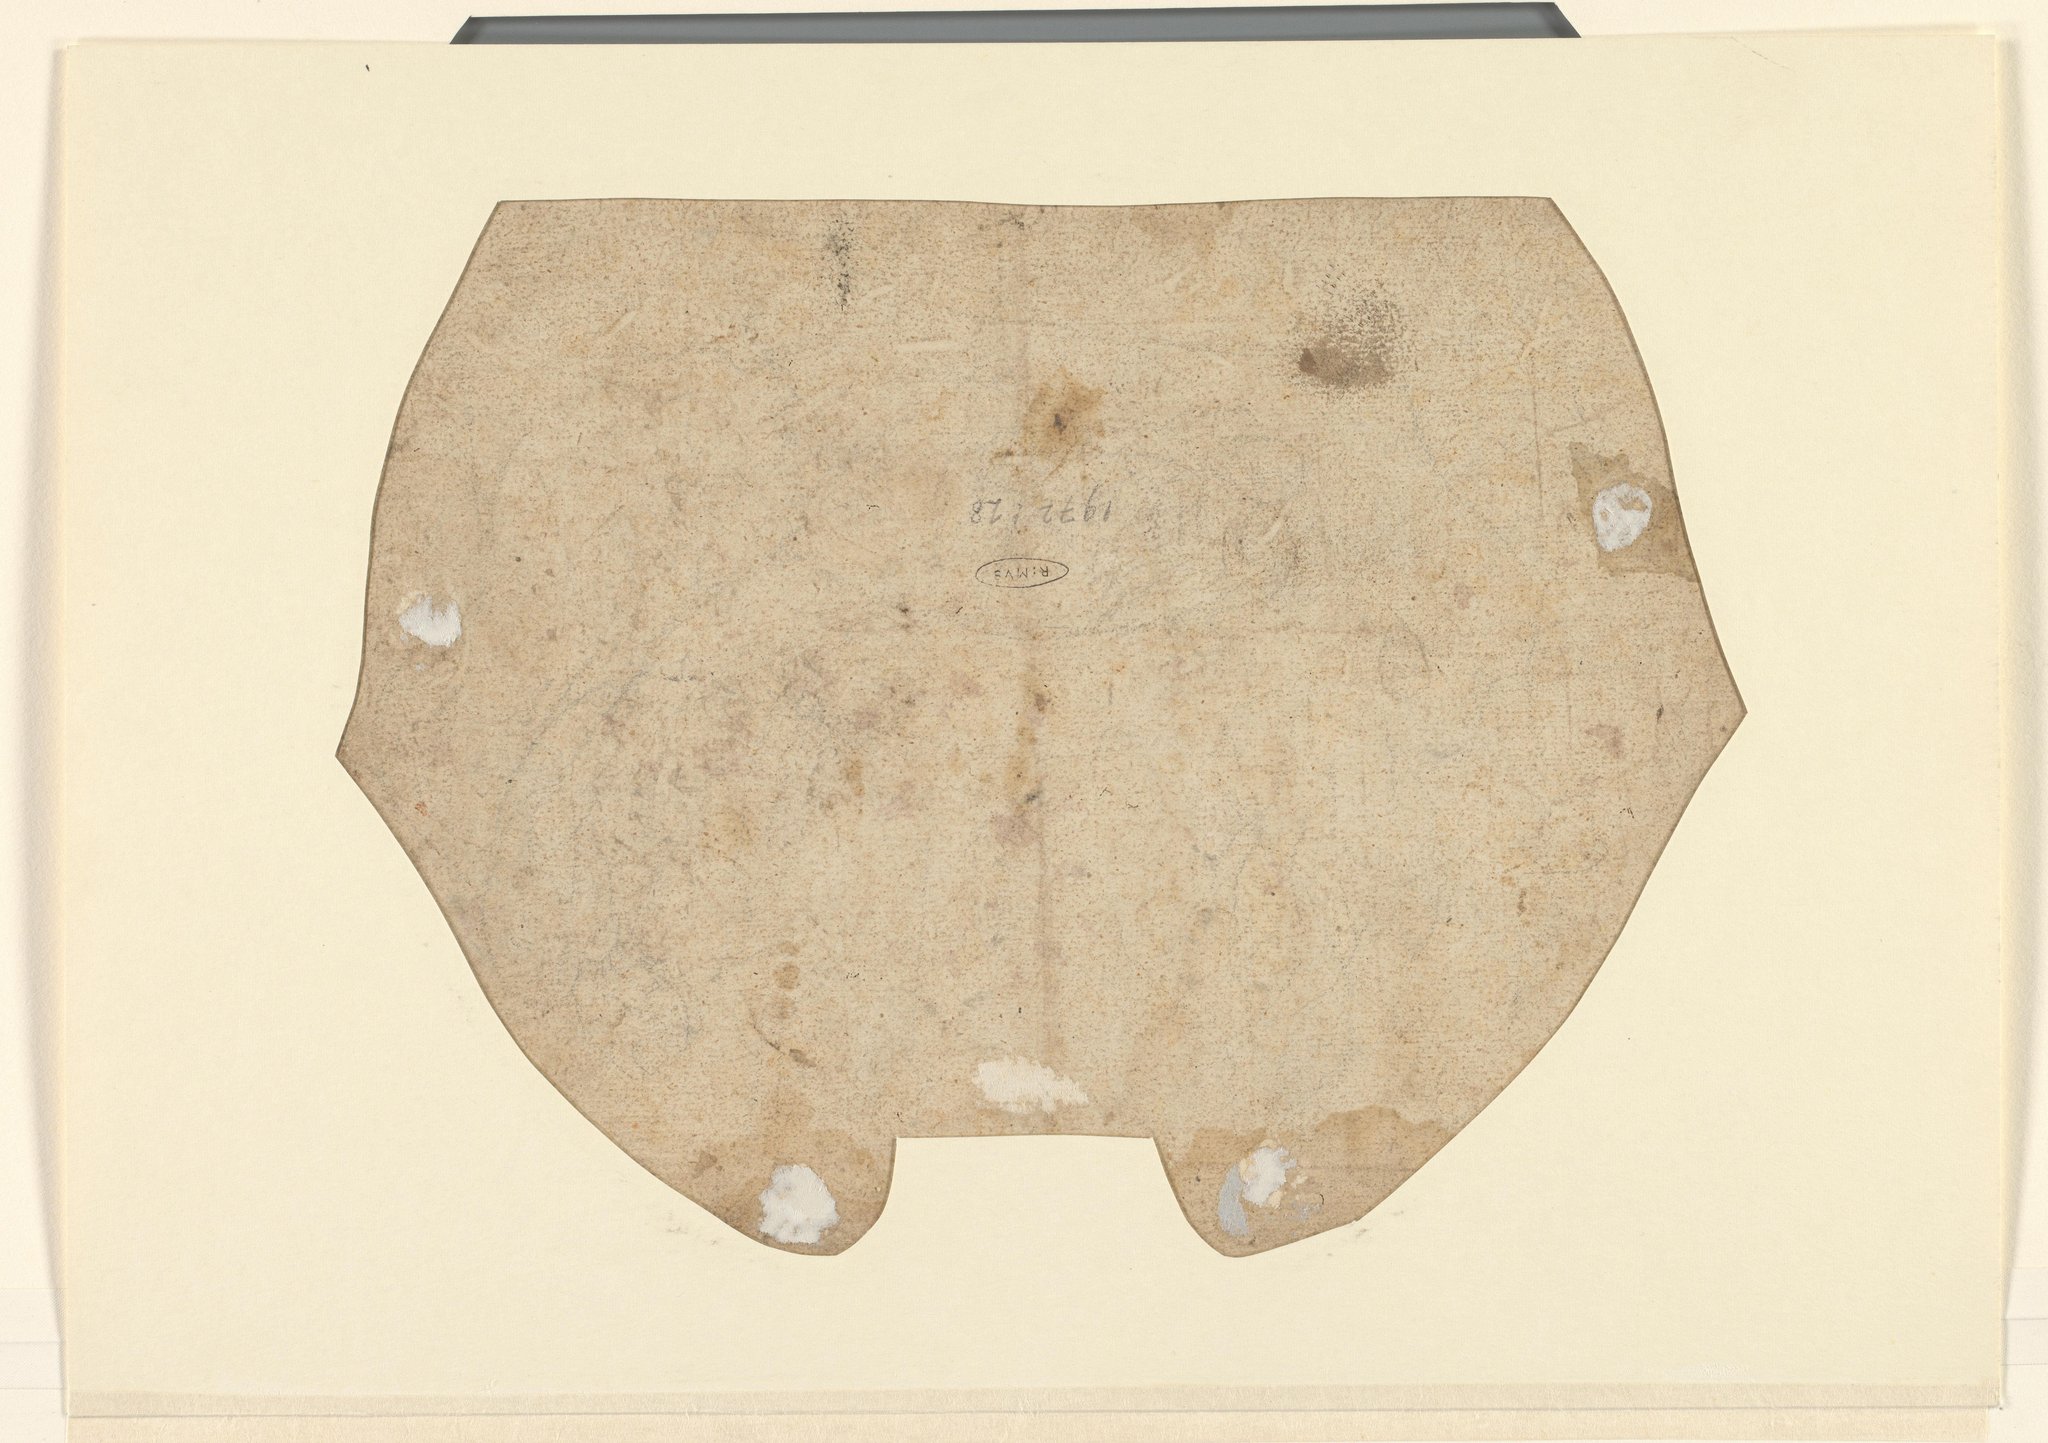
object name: drawing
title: Schets voor figuur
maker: lancelot blondeel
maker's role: draughtsman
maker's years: 1498-1561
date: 1545-1550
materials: chalk, paper